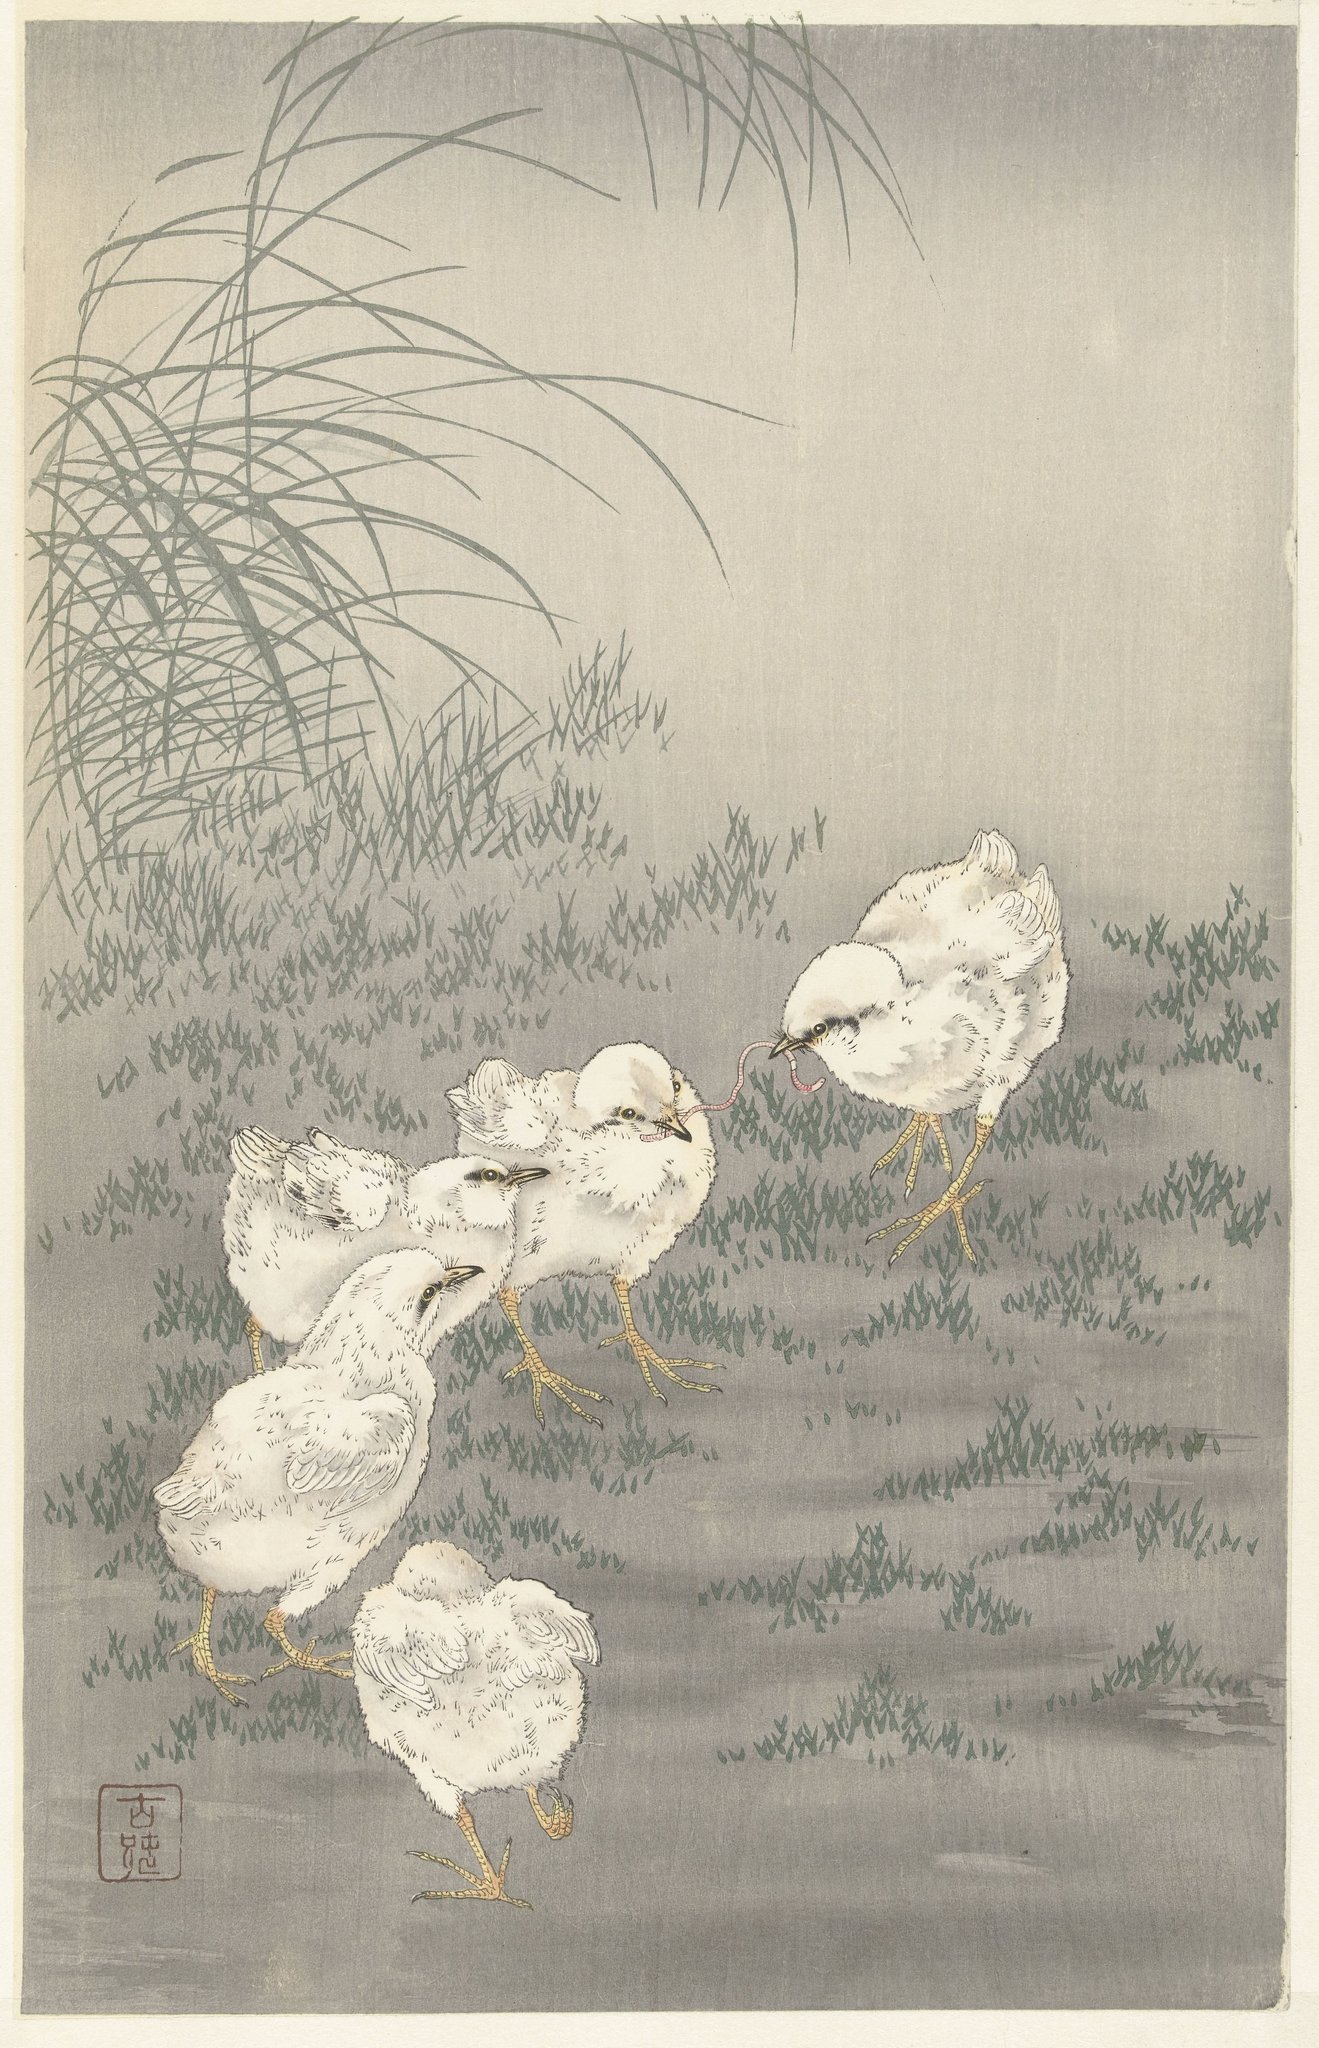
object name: print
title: Vijf kuikens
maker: ohara koson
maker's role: print maker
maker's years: 1877-1945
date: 1900-1936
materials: paper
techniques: woodcut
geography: japan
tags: fowl (cock, hen, chicken, etc.) (+ young animal)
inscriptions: collector's mark: Lugt 2228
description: Vijf kuikens in het gras, waarvan twee aan dezelfde worm trekkend.